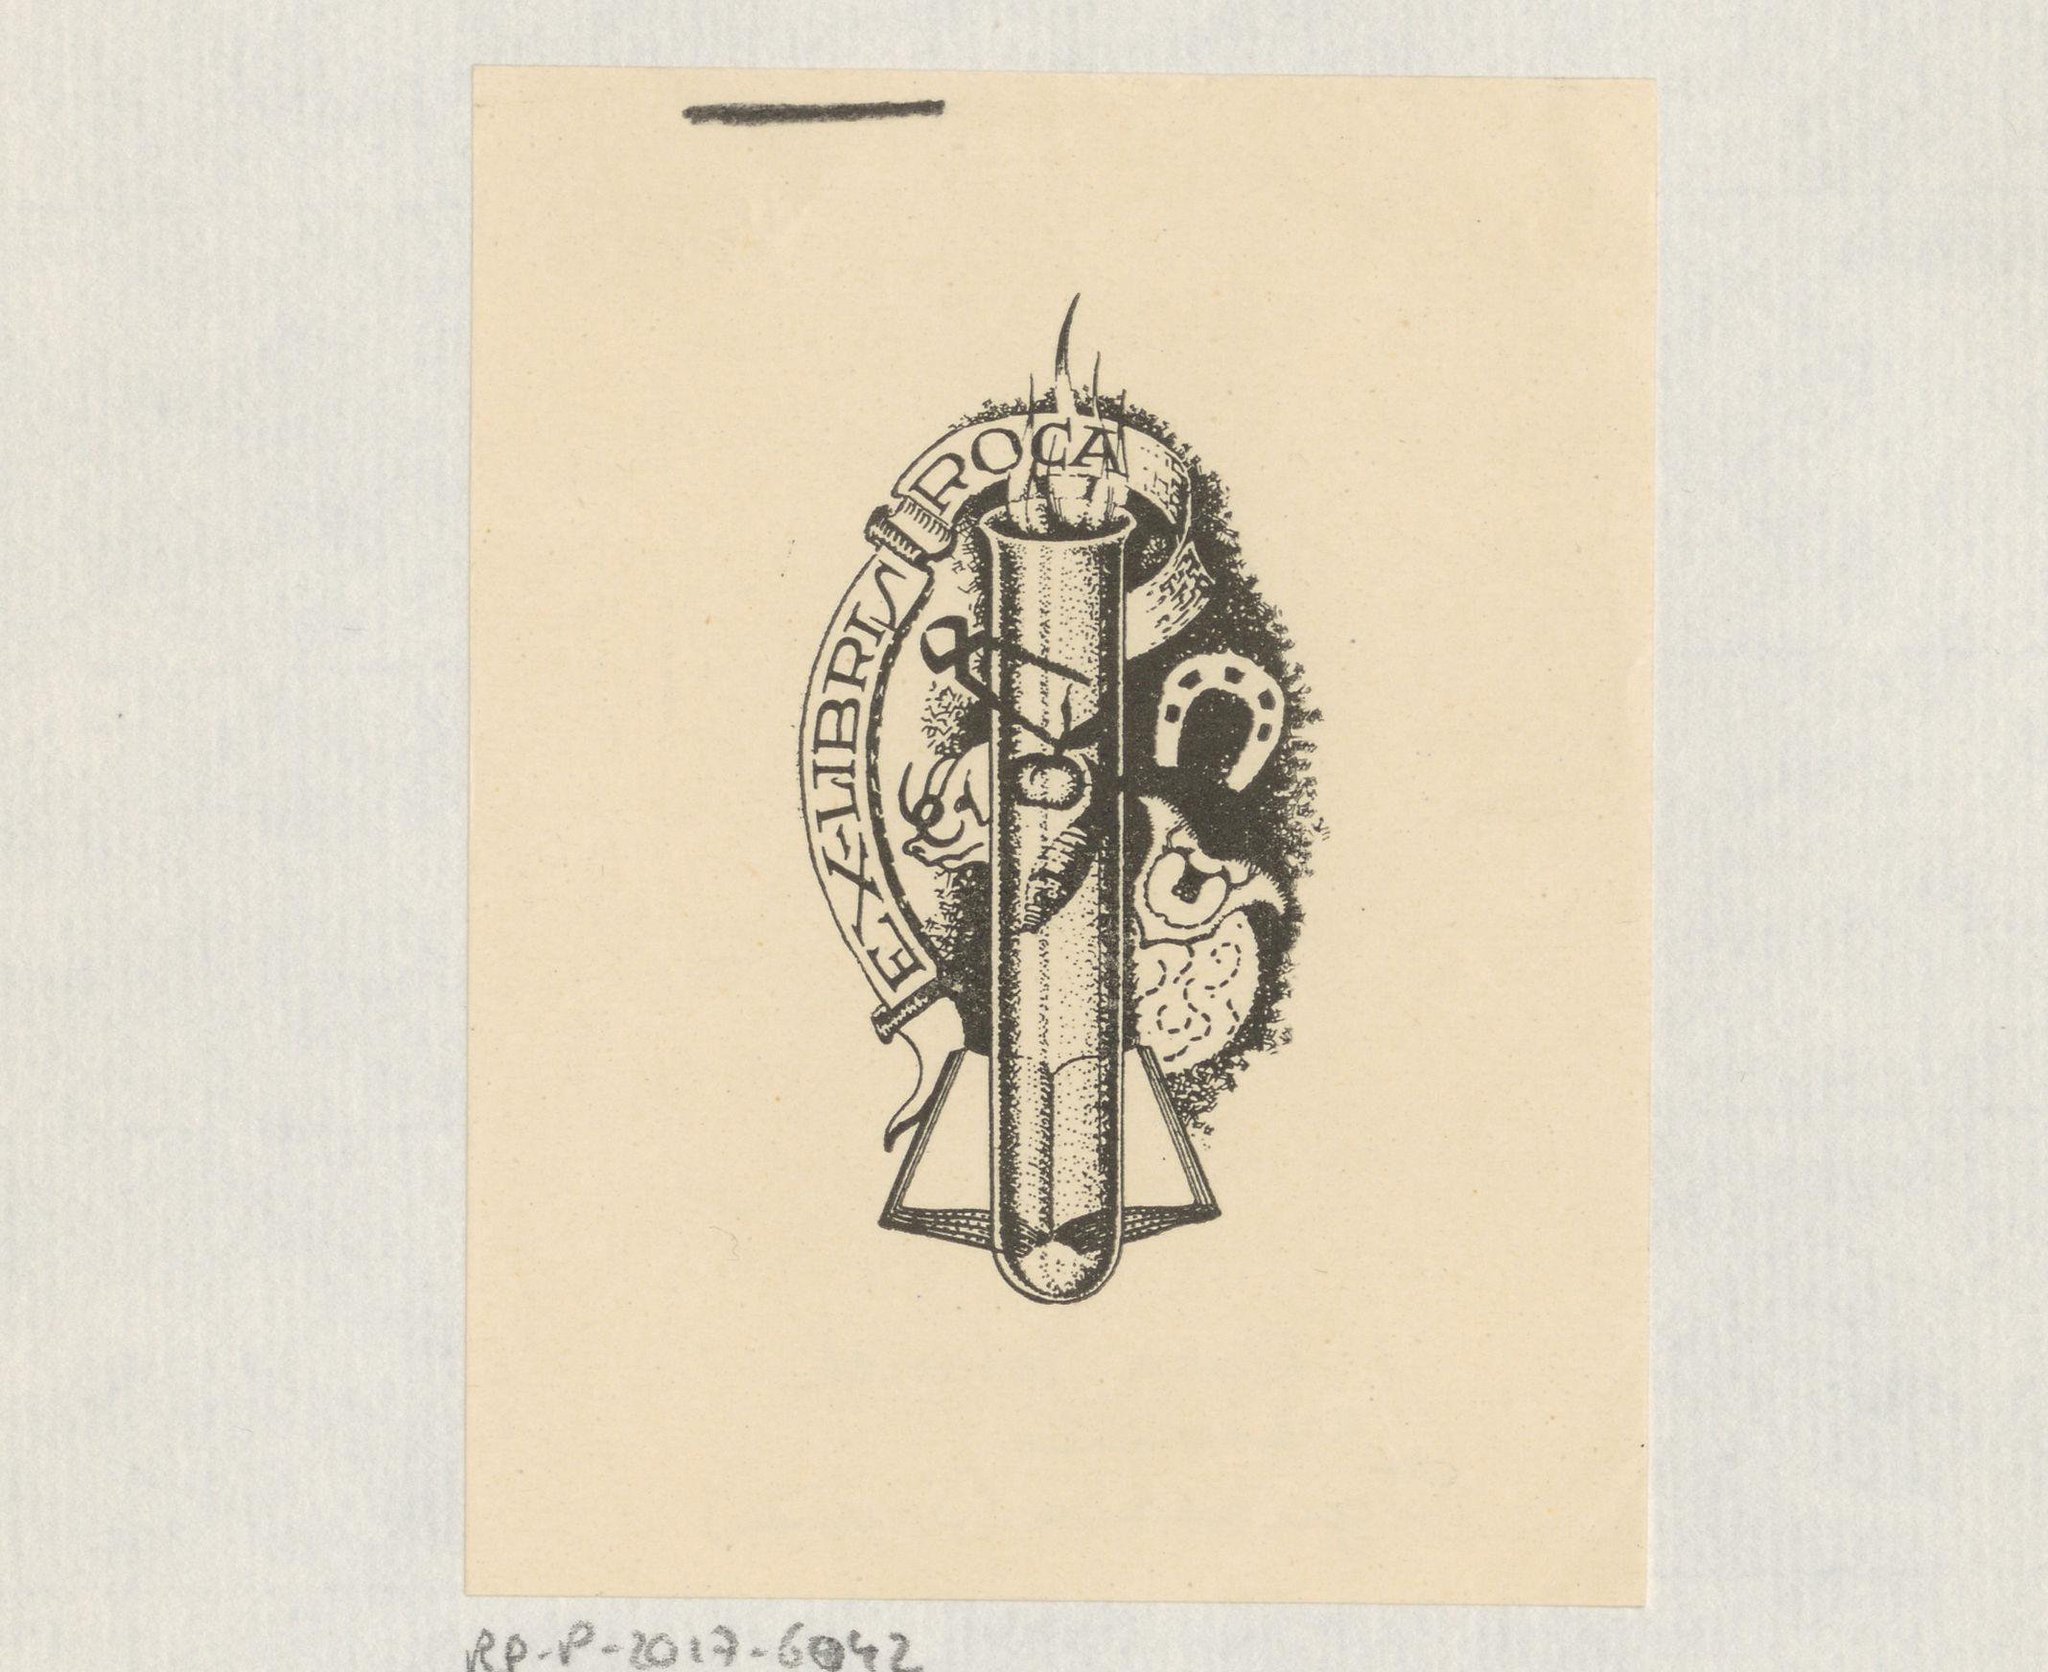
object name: bookplate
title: Ex libris van L. Roca Jolonch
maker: Anonymous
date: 1900-1999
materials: paper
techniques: printing block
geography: spain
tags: chemistry, book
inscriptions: inscription: ‘L. Roca Jolonch/ Veterinar/ (Spanien)’